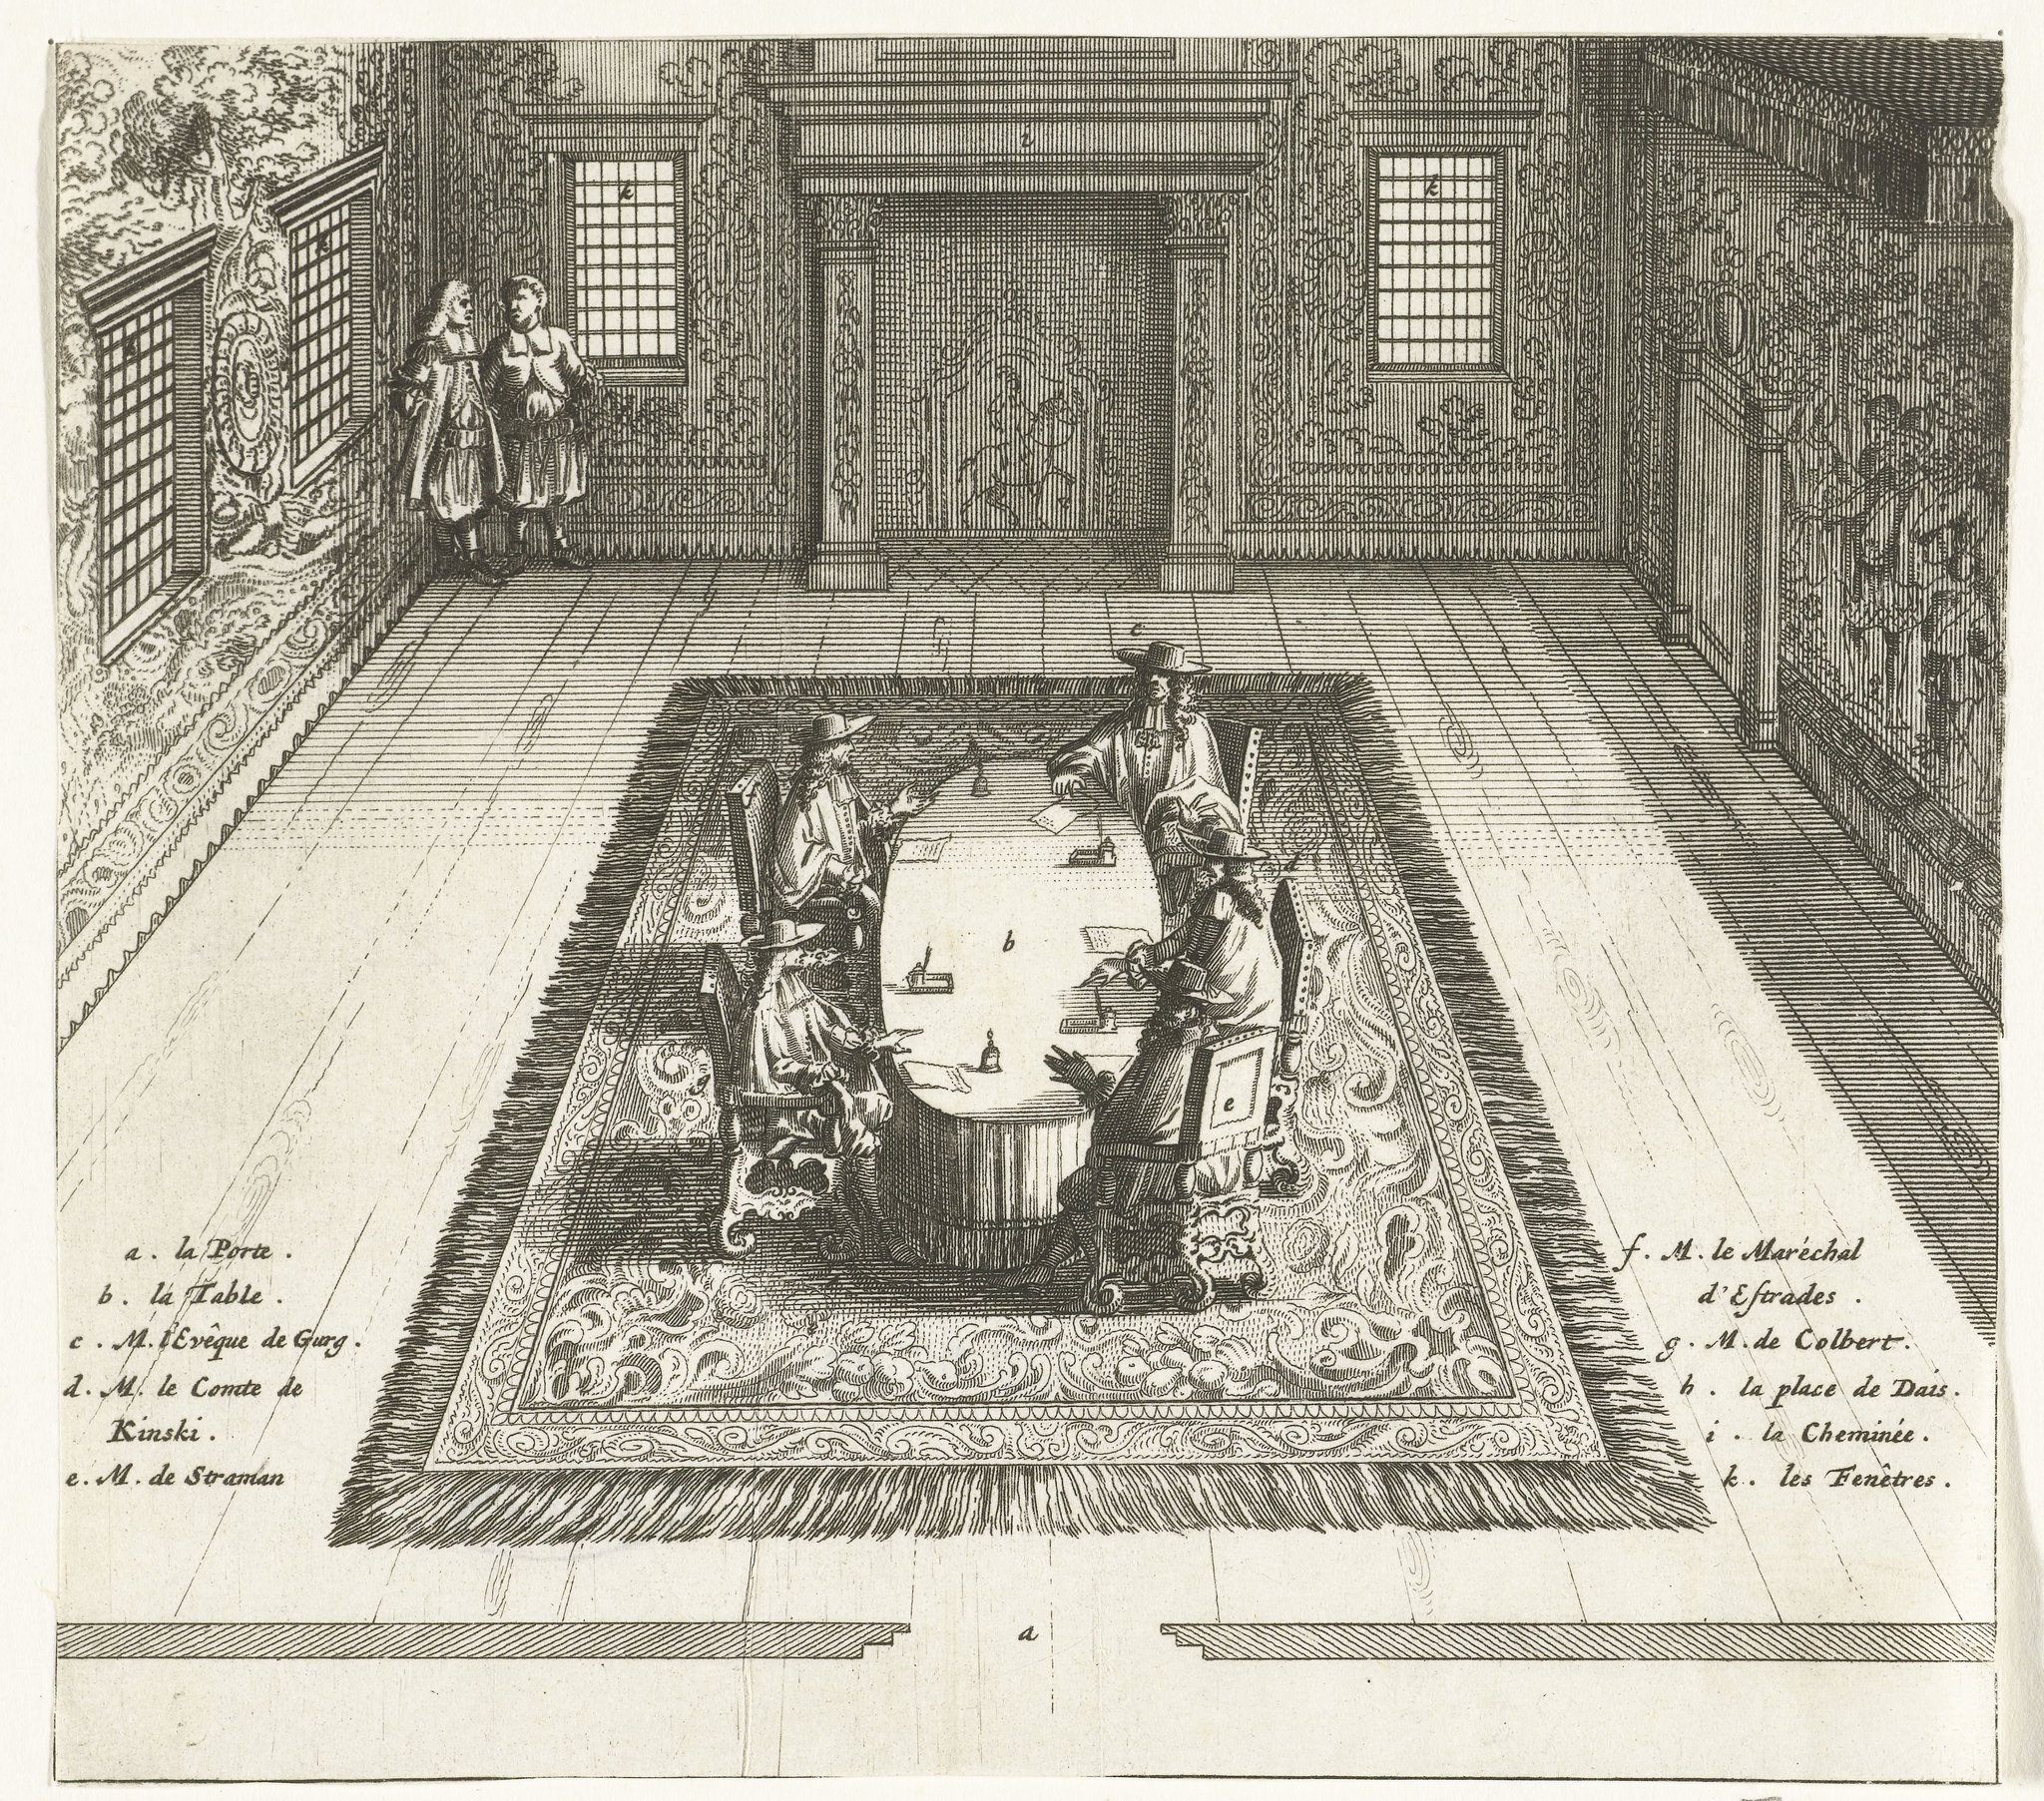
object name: print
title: Het ondertekenen van het vredesverdrag tussen Frankrijk en de Duitse Keizer, 5 februari 1679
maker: Anonymous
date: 1678-1680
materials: paper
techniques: etching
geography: northern netherlands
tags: signing of peace treaty, concluding the peace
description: Het ondertekenen van het vredesverdrag tussen Frankrijk en de Duitse Keizer in de Trèveszaal in het stadhuis van Nijmegen, 5 februari 1679. Interieur met de vijf gezanten zittend rond een tafel. Onderaan in de voorstelling de verklaring van de letters a-k in het Frans.